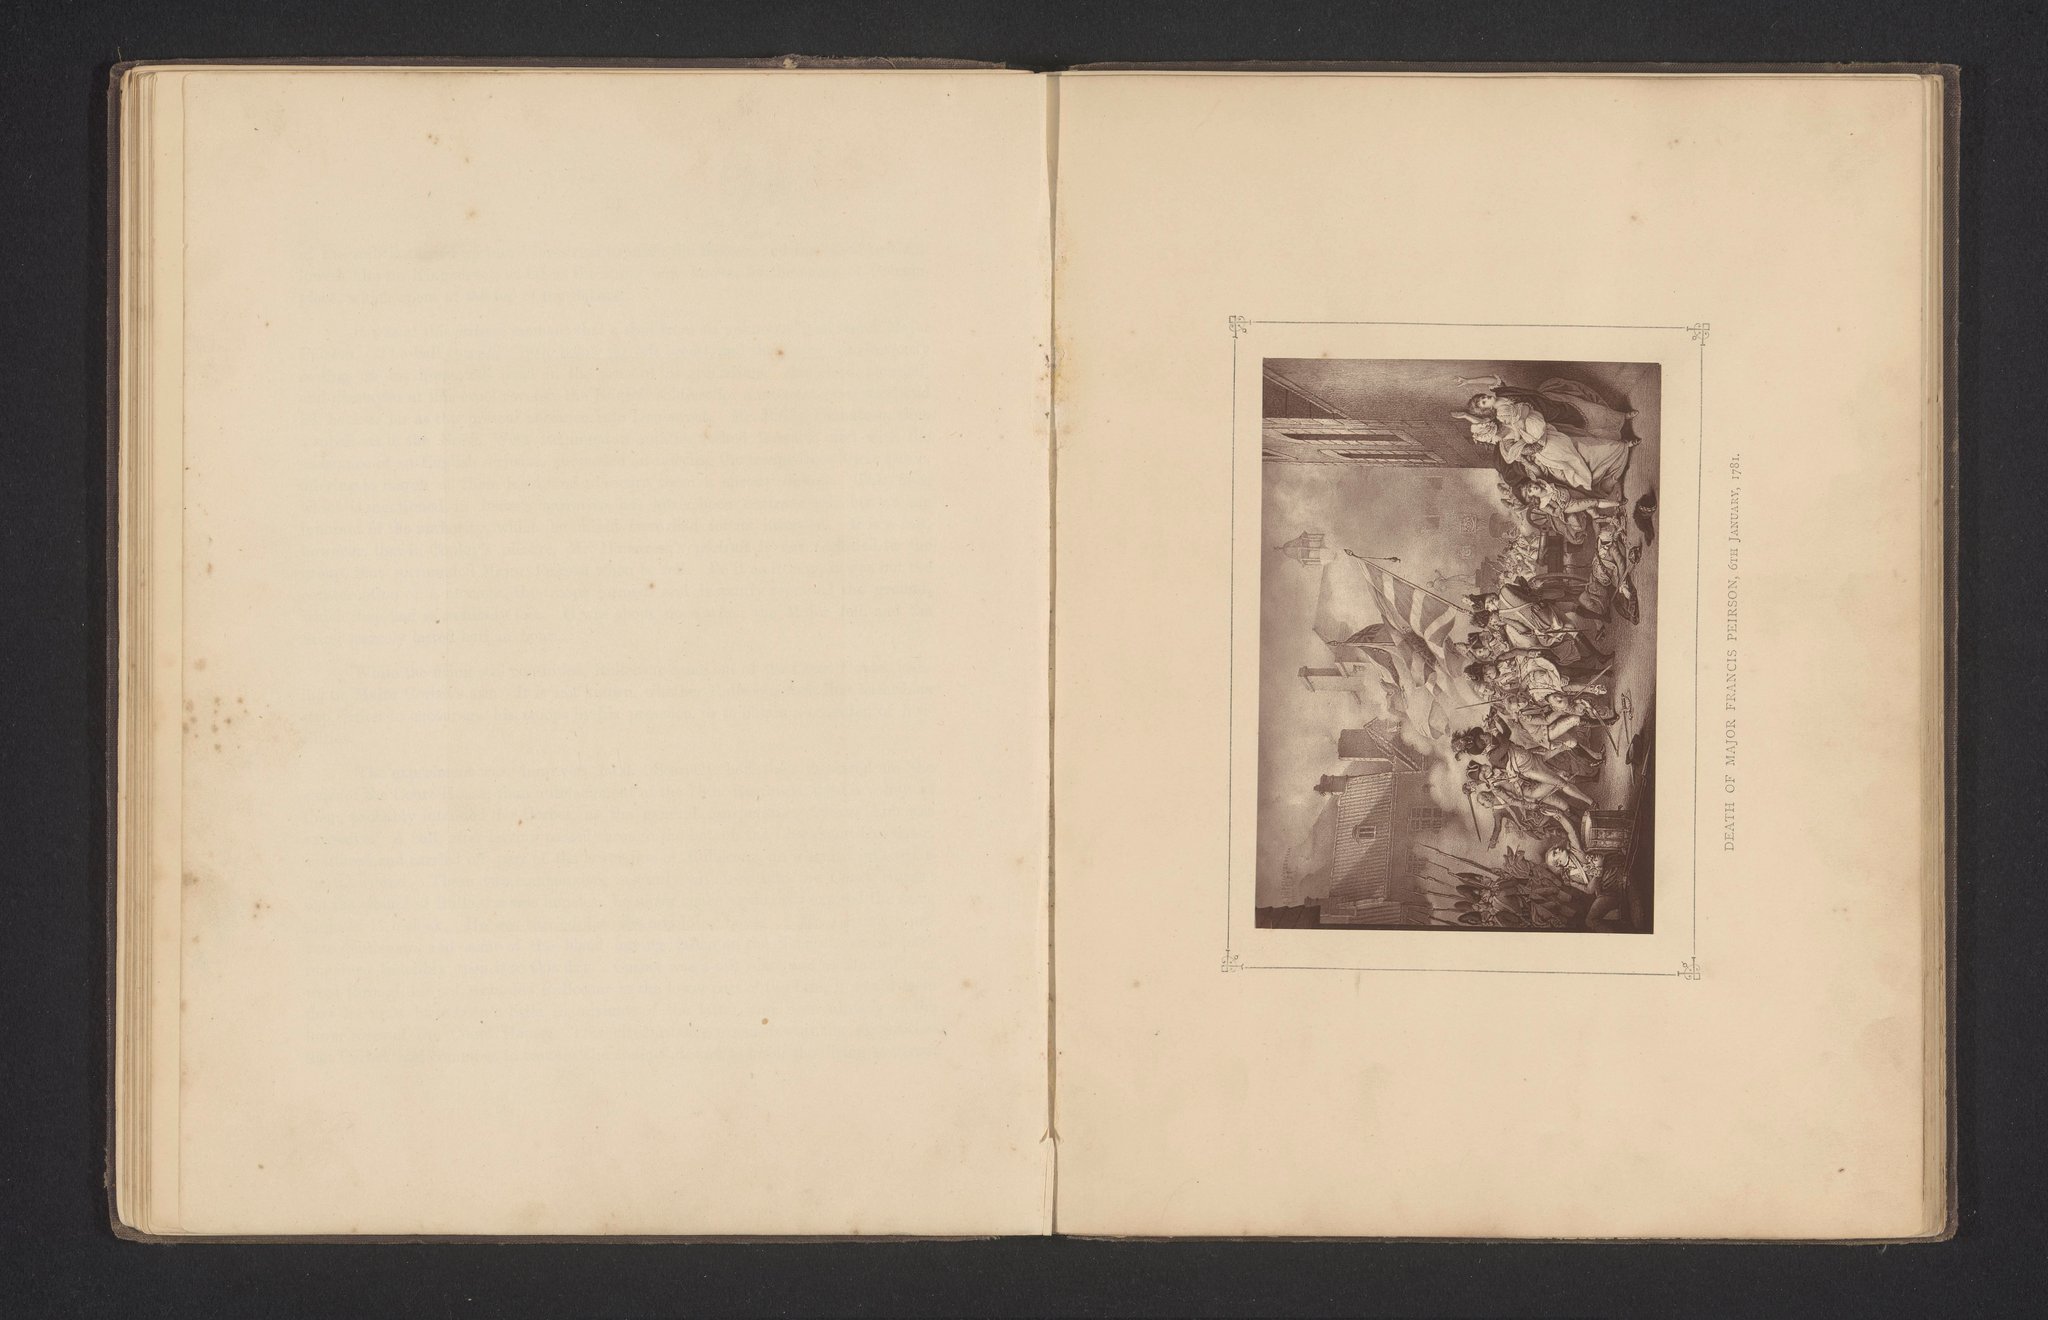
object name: reproduction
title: Fotoreproductie van het schilderij The Death of Major Peirson, 6 January 1781 door John Singleton Copley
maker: Anonymous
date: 1871-1881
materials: paper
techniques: woodburytype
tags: battle, picture, painting